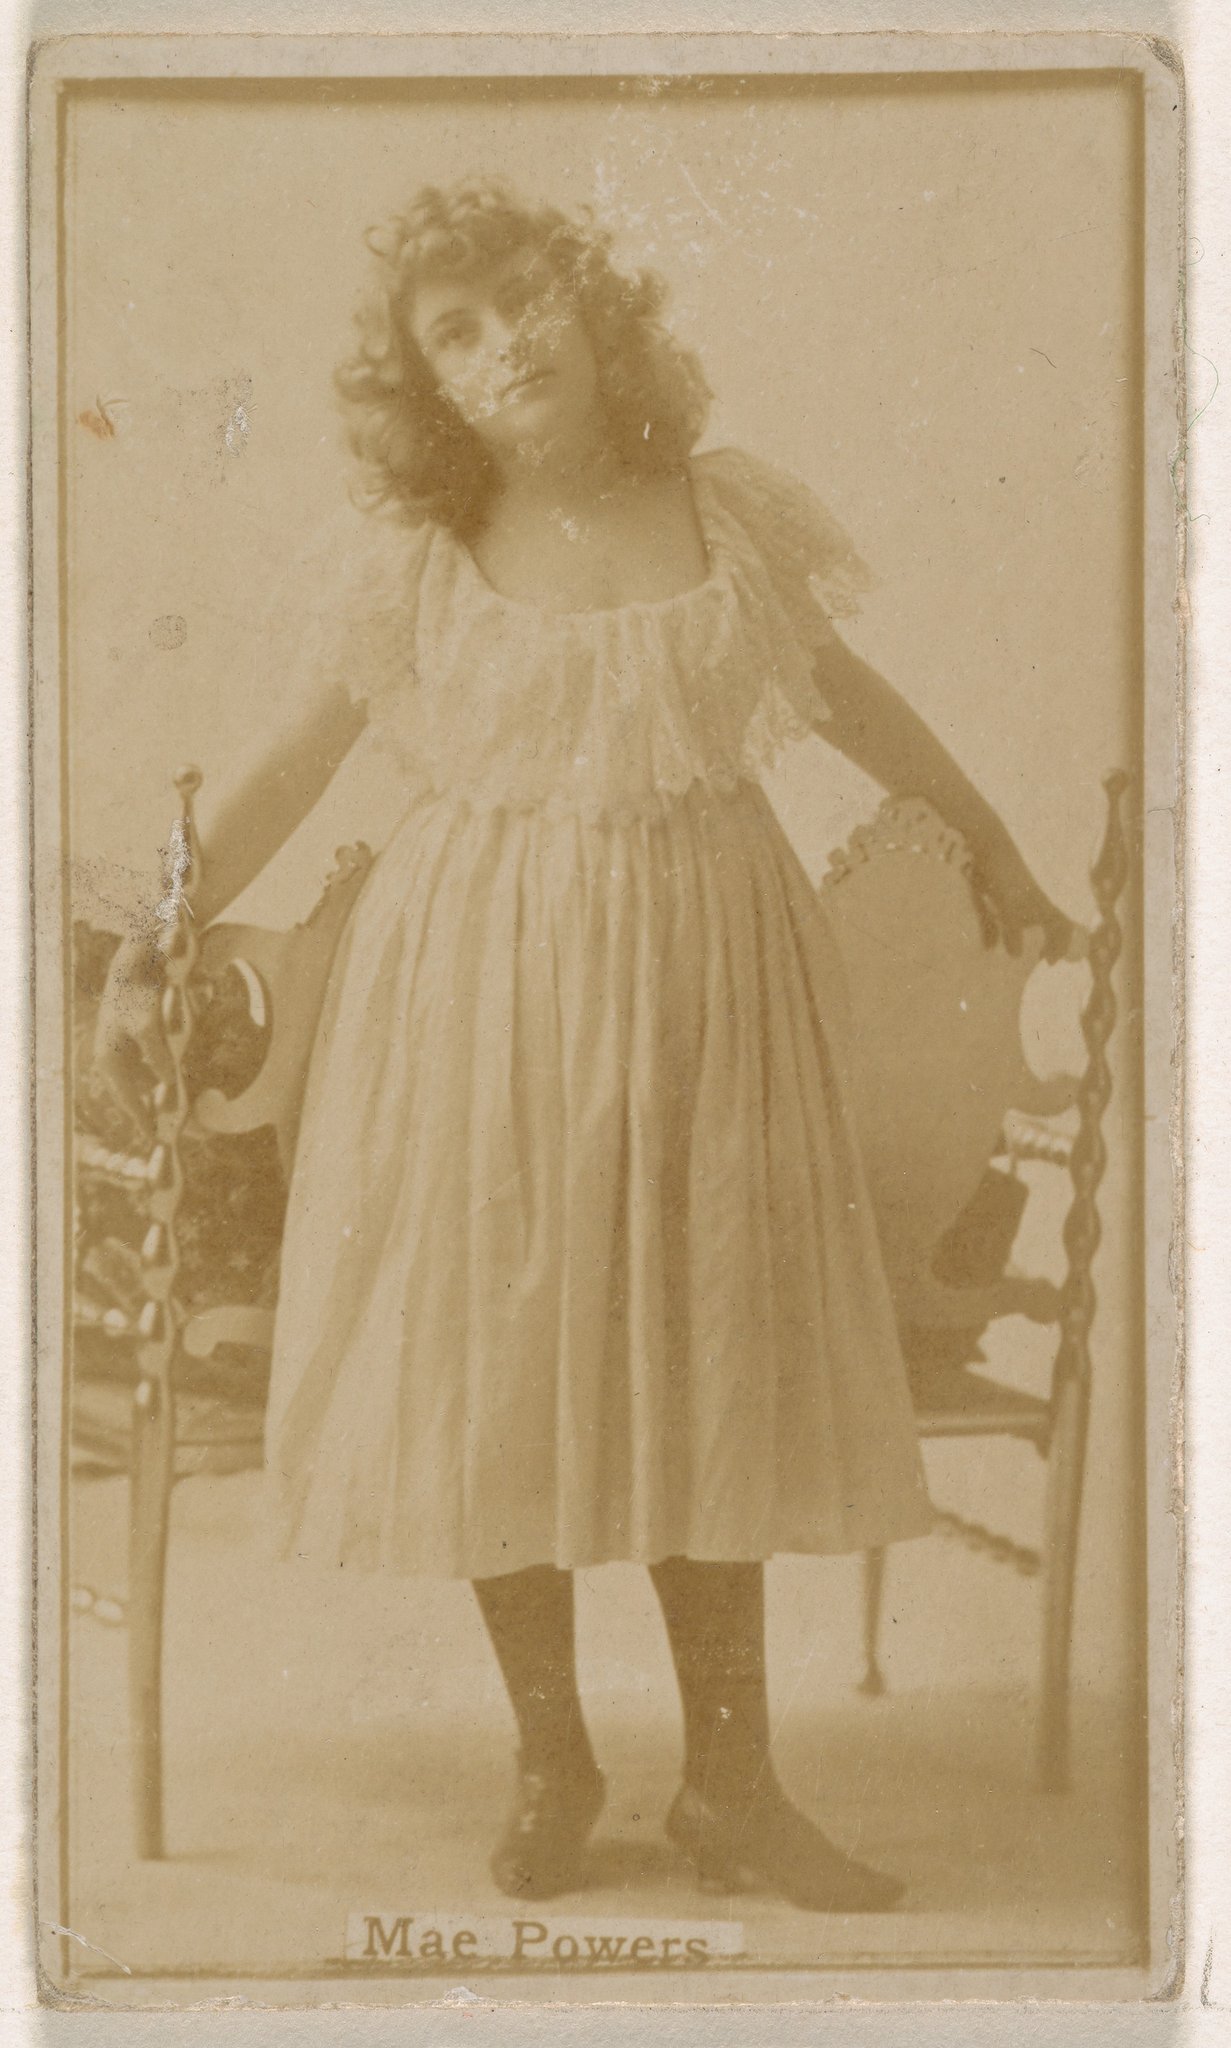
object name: photograph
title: Mae Powers, from the Actresses series (N245) issued by Kinney Brothers to promote Sweet Caporal Cigarettes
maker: kinney brothers tobacco company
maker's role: publisher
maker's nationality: american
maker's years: 1869-2011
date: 1890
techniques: albumen silver print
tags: portraits,women,actresses